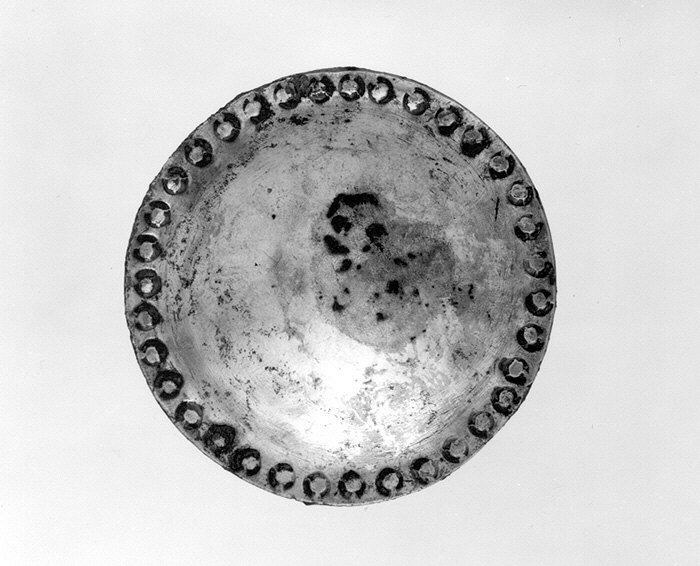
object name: appliqué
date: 500-301 BCE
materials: gilt silver, silver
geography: thrace